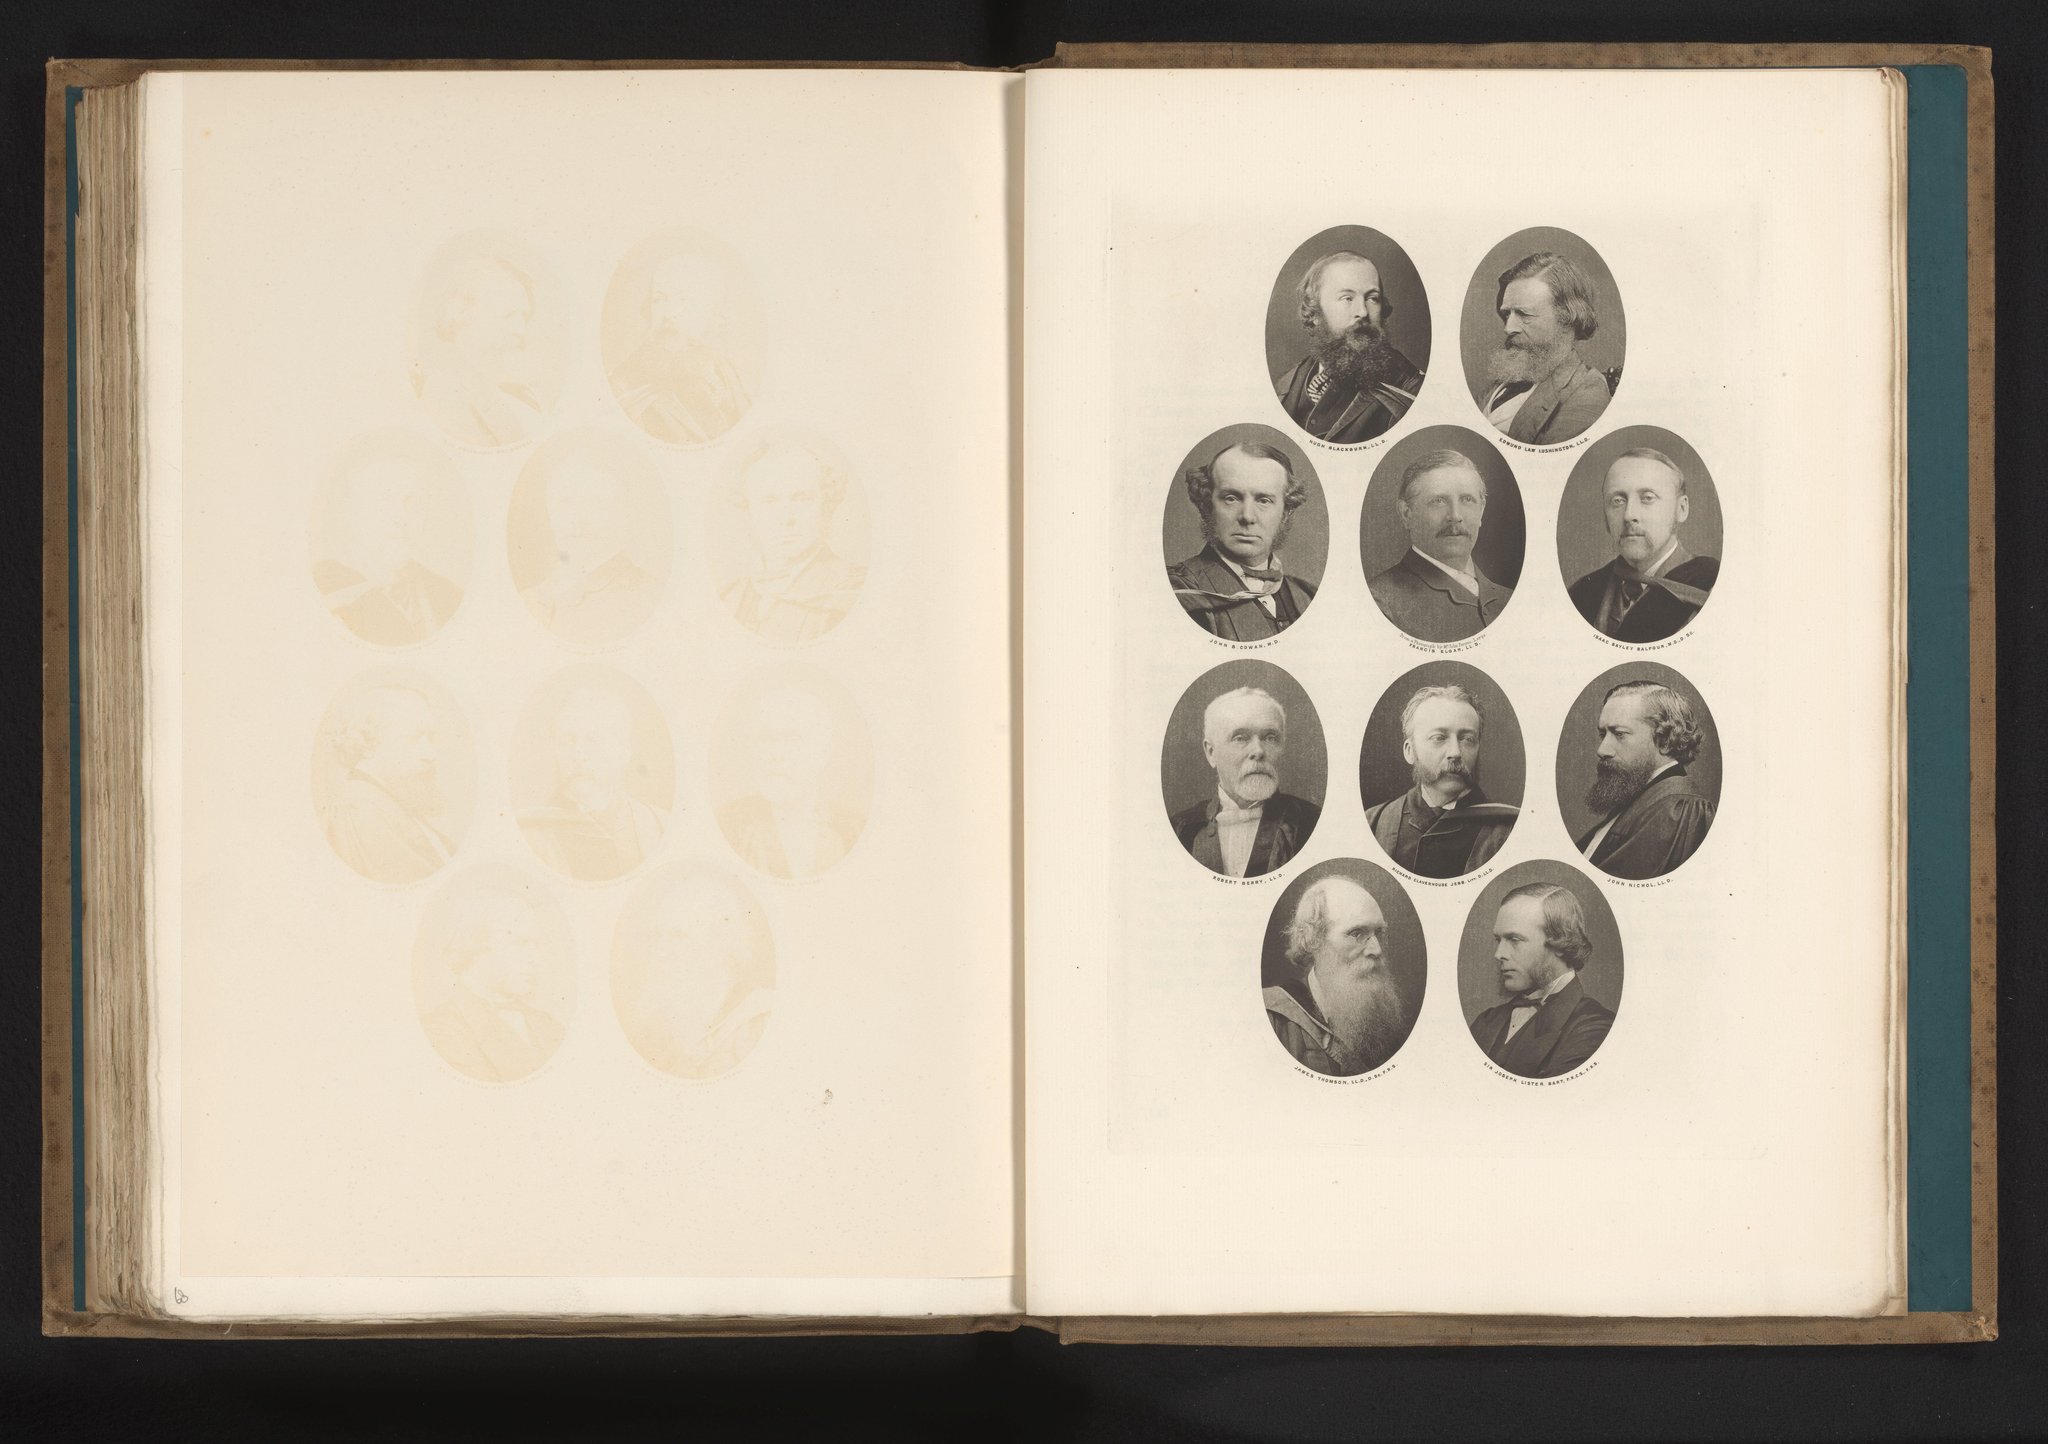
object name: photomechanical print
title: Tien portretten van voorzitters van de universiteit van Glasgow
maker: Anonymous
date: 1886-1891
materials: paper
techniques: photoaquatint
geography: glasgow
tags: glasgow, engineer, politician, historical persons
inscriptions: inscription: ‘Hugh Blackburn, LL.D./ Edmund Law Lushinton, LL.D./ John B. Cowan, M.D./ Francis Elgar, LL.D./ Isaac Bayley Balfour, M.D., D.SC/ Robert Berry, LL.D./ Richard Claverhouse Jebb, Litt. D. LL.D./ John Nichol, LL.D./ James Thomson, L.D., D.Sc. F.R.S./ Sir Joseph Lister Bart, F.R.C.S,. F.R.S.’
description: Prent op vijfendertigste ongenummerde pagina na pagina 128.